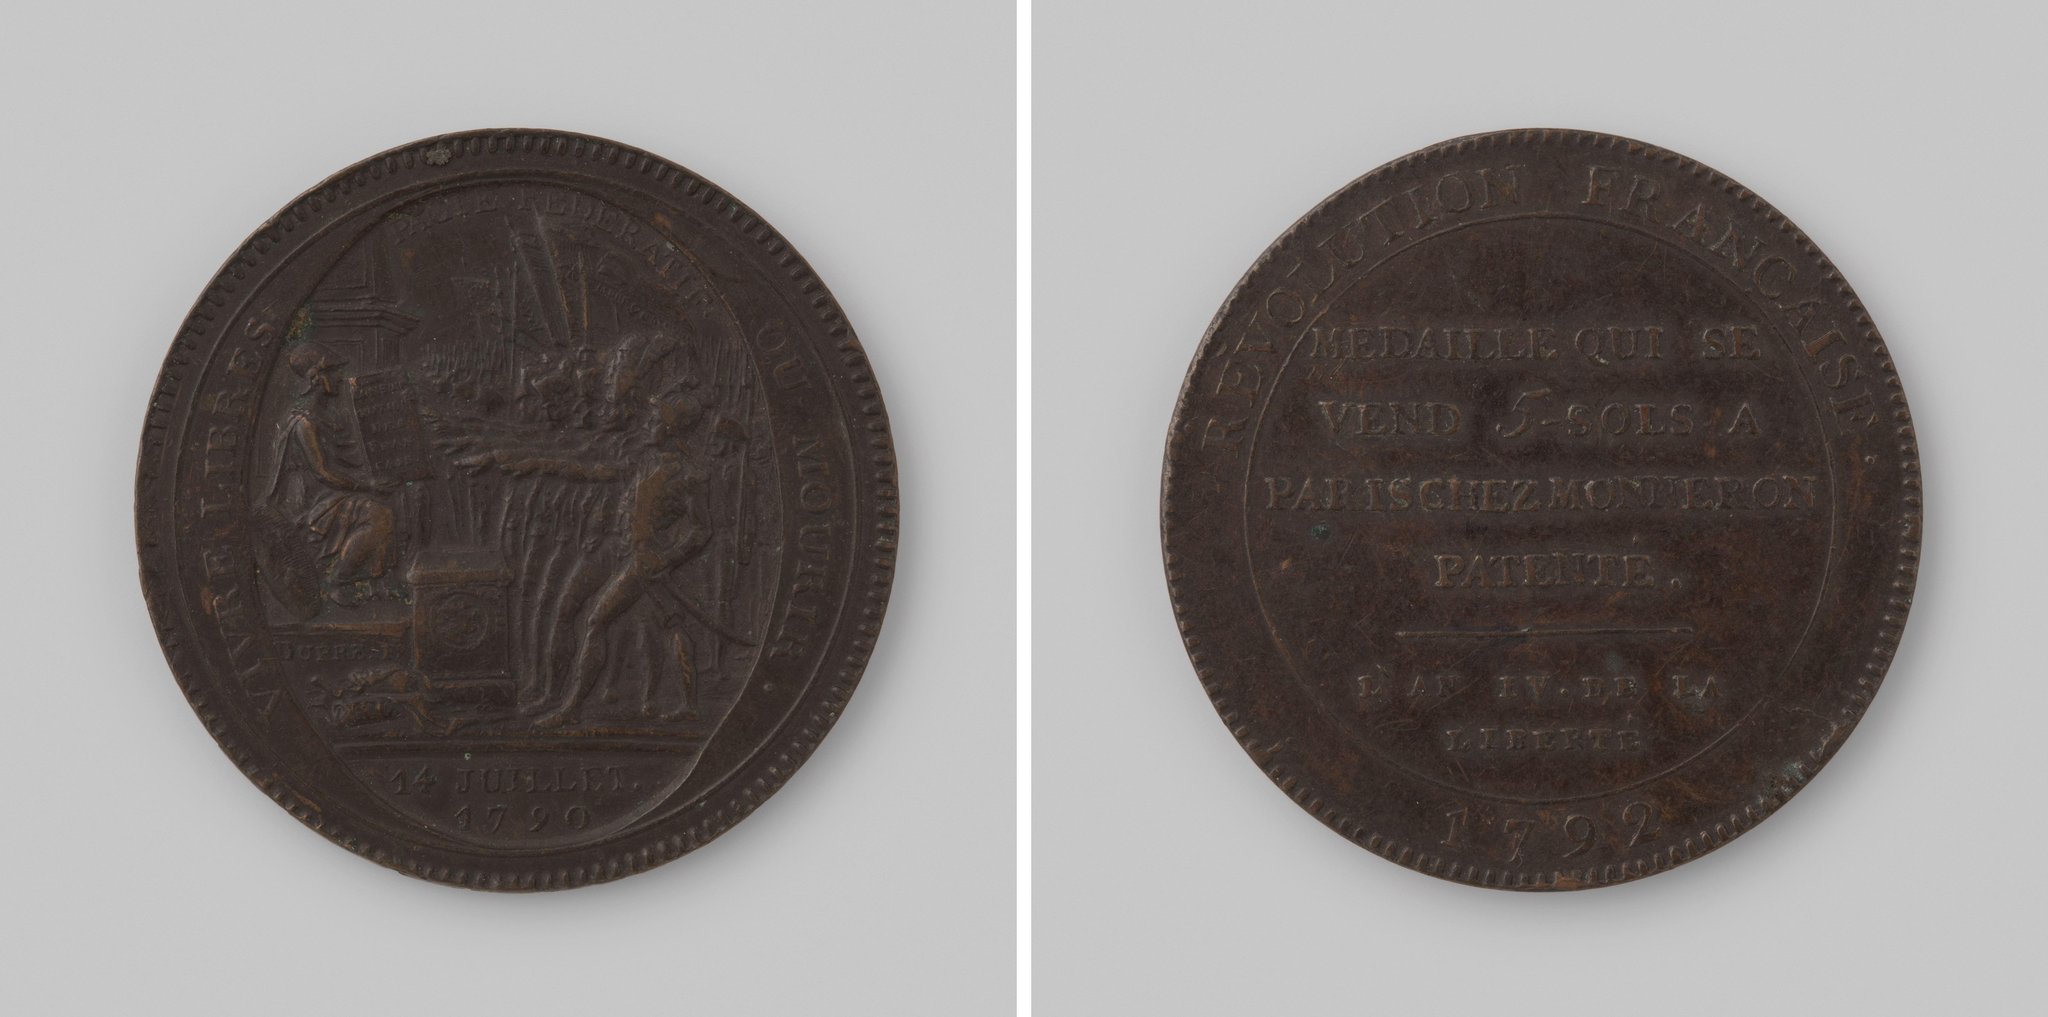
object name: coin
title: Frankrijk, particuliere 5 sols van de gebroeders Monneron,1792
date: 1792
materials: bronze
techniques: striking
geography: paris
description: Bronzen munt. Voorzijde: afbeelding van voor de vrijheid stijdende personen met een allegorische voorstelling. Keerzijde: vierregelig opschrift, waarin waarde-aanduiding. Daaronder jaartal in nieuwe telling: An 4. Jaartal onderaan. Randschrift.